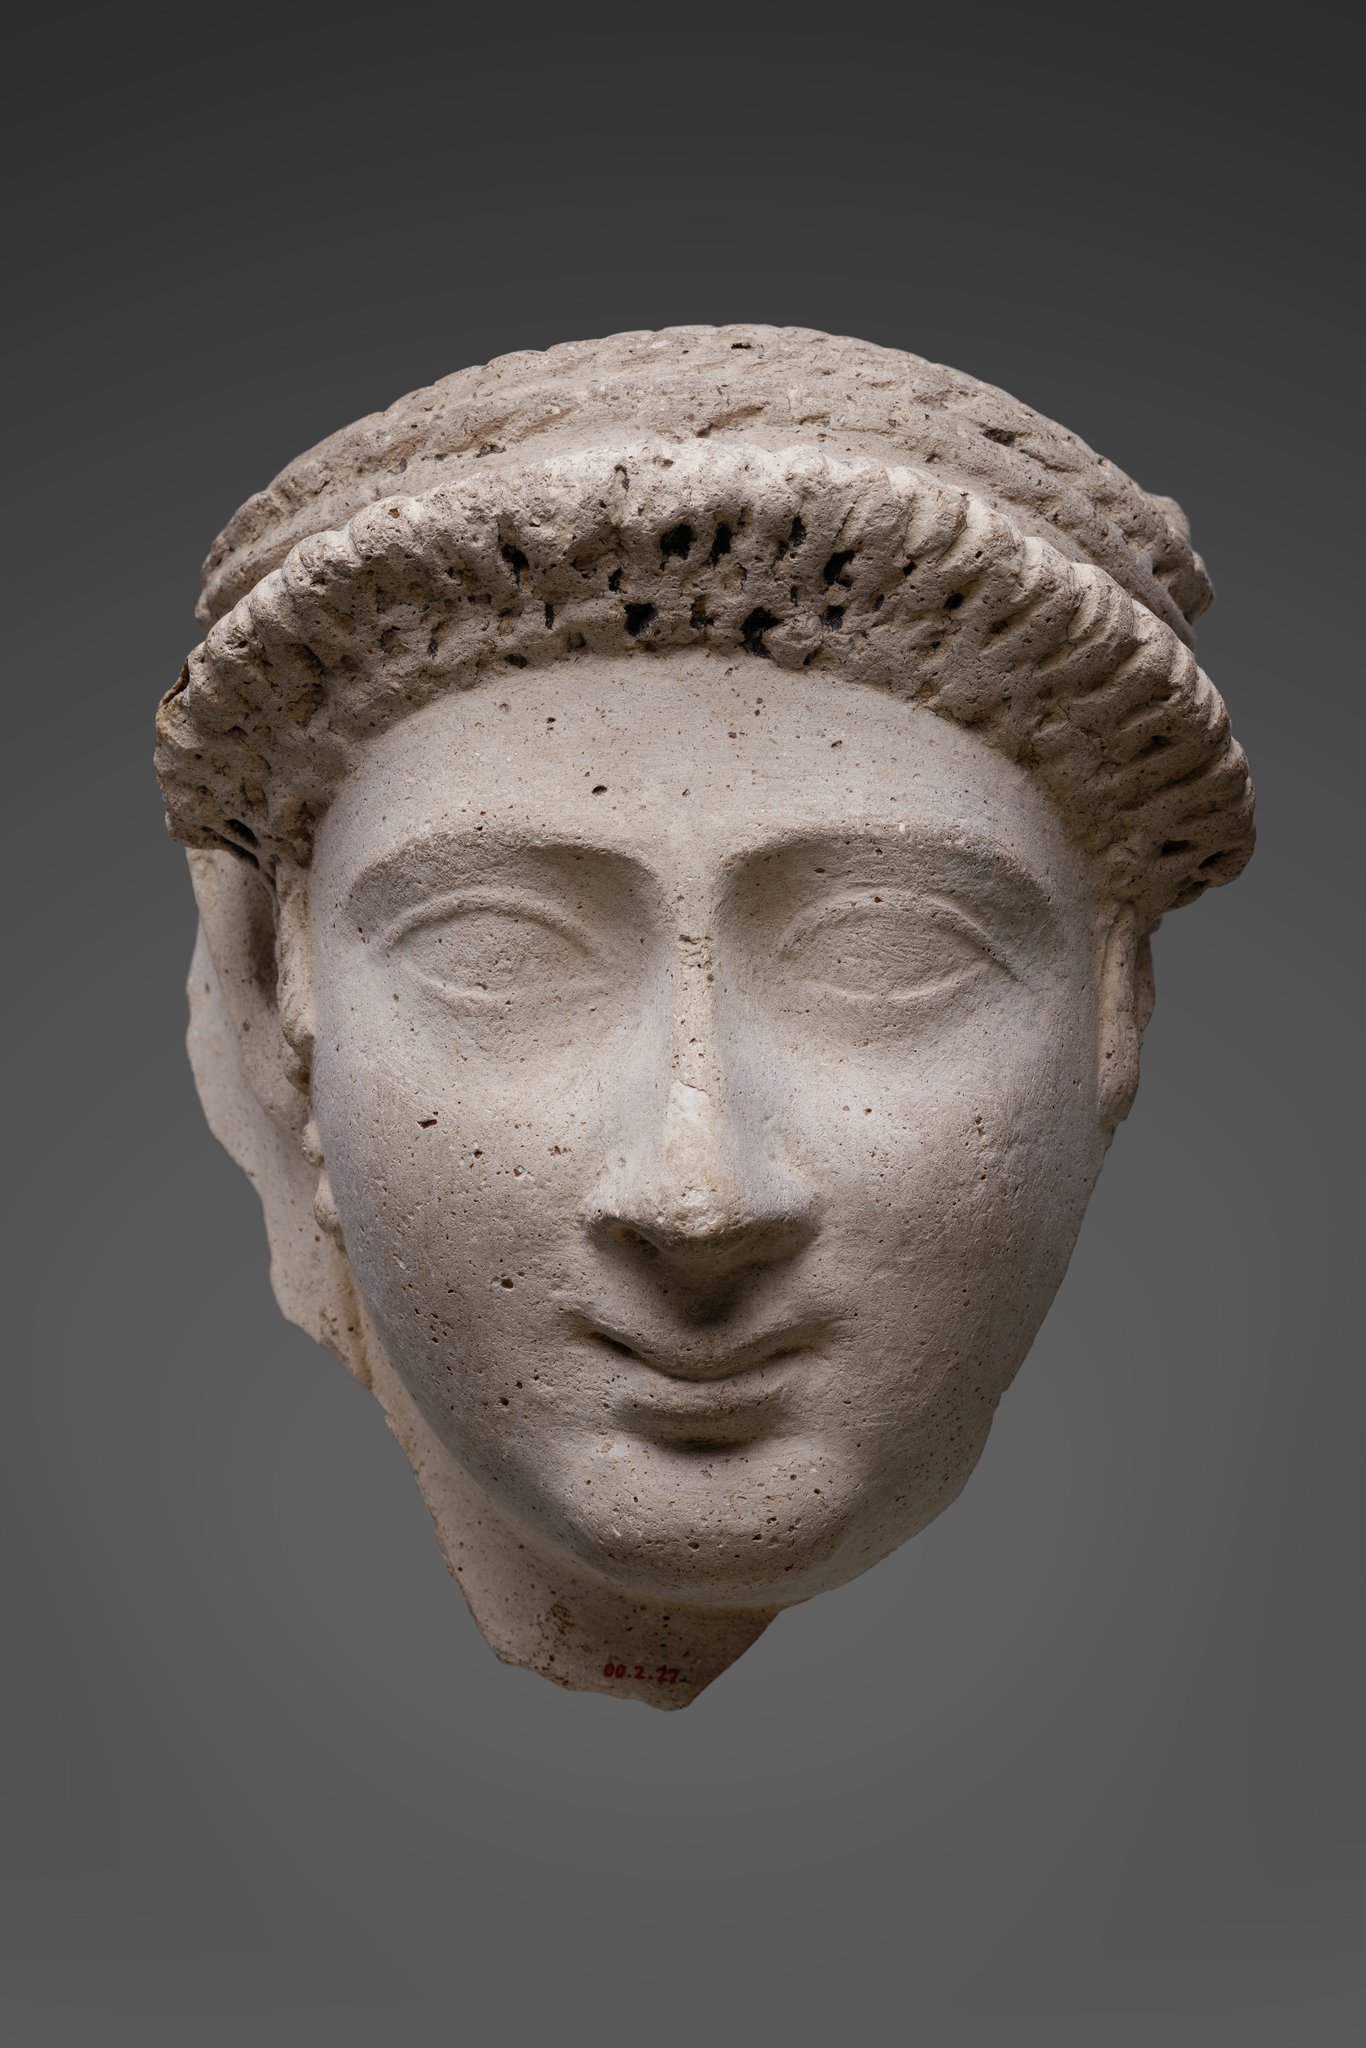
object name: mask, woman, loop earring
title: Mask of a woman with an ornate curled bang and loop earrings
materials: paint, plaster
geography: egypt